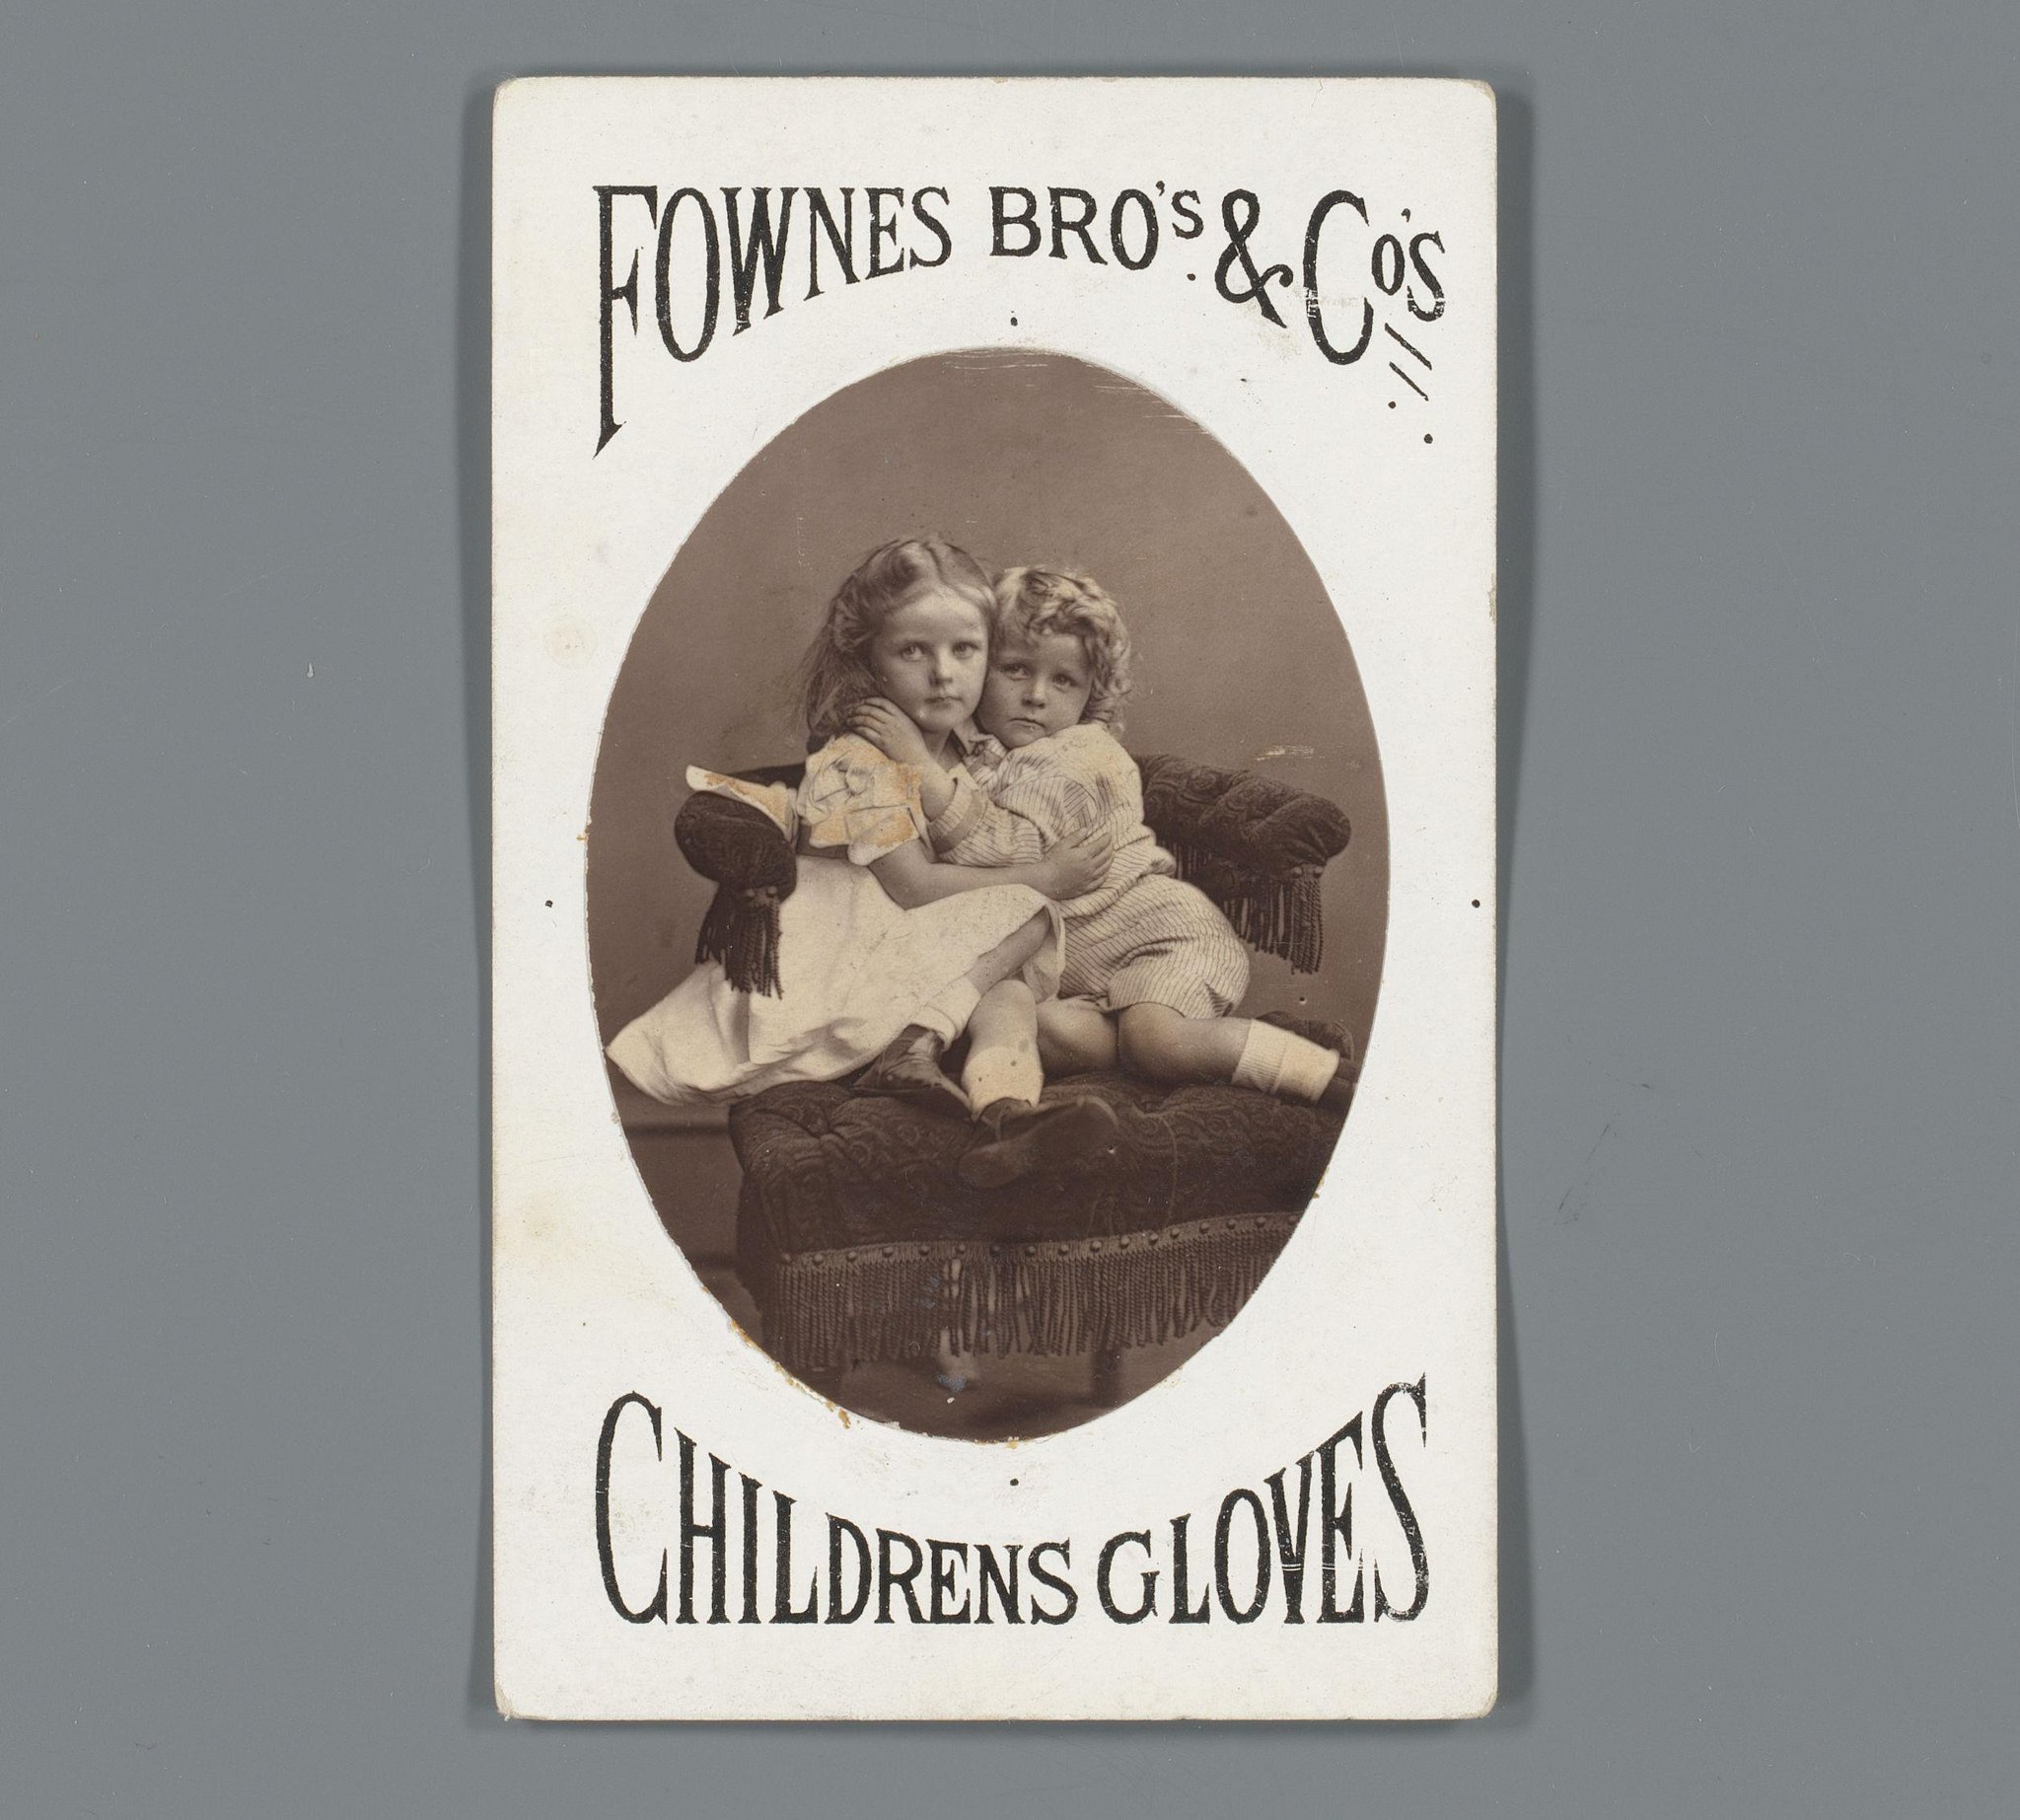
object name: photograph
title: Portret van twee kinderen in een fauteuil als reclame voor kinderhandschoenen van Fownes Brothers & Cos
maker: Anonymous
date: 1860-1940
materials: cardboard, photographic support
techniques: carbon print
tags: advertising, gloves, mittens, etc., child, embracing each other, kissing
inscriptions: inscription: ‘FOWNES BRO'S & COS/ CHILDRENS GLOVES’